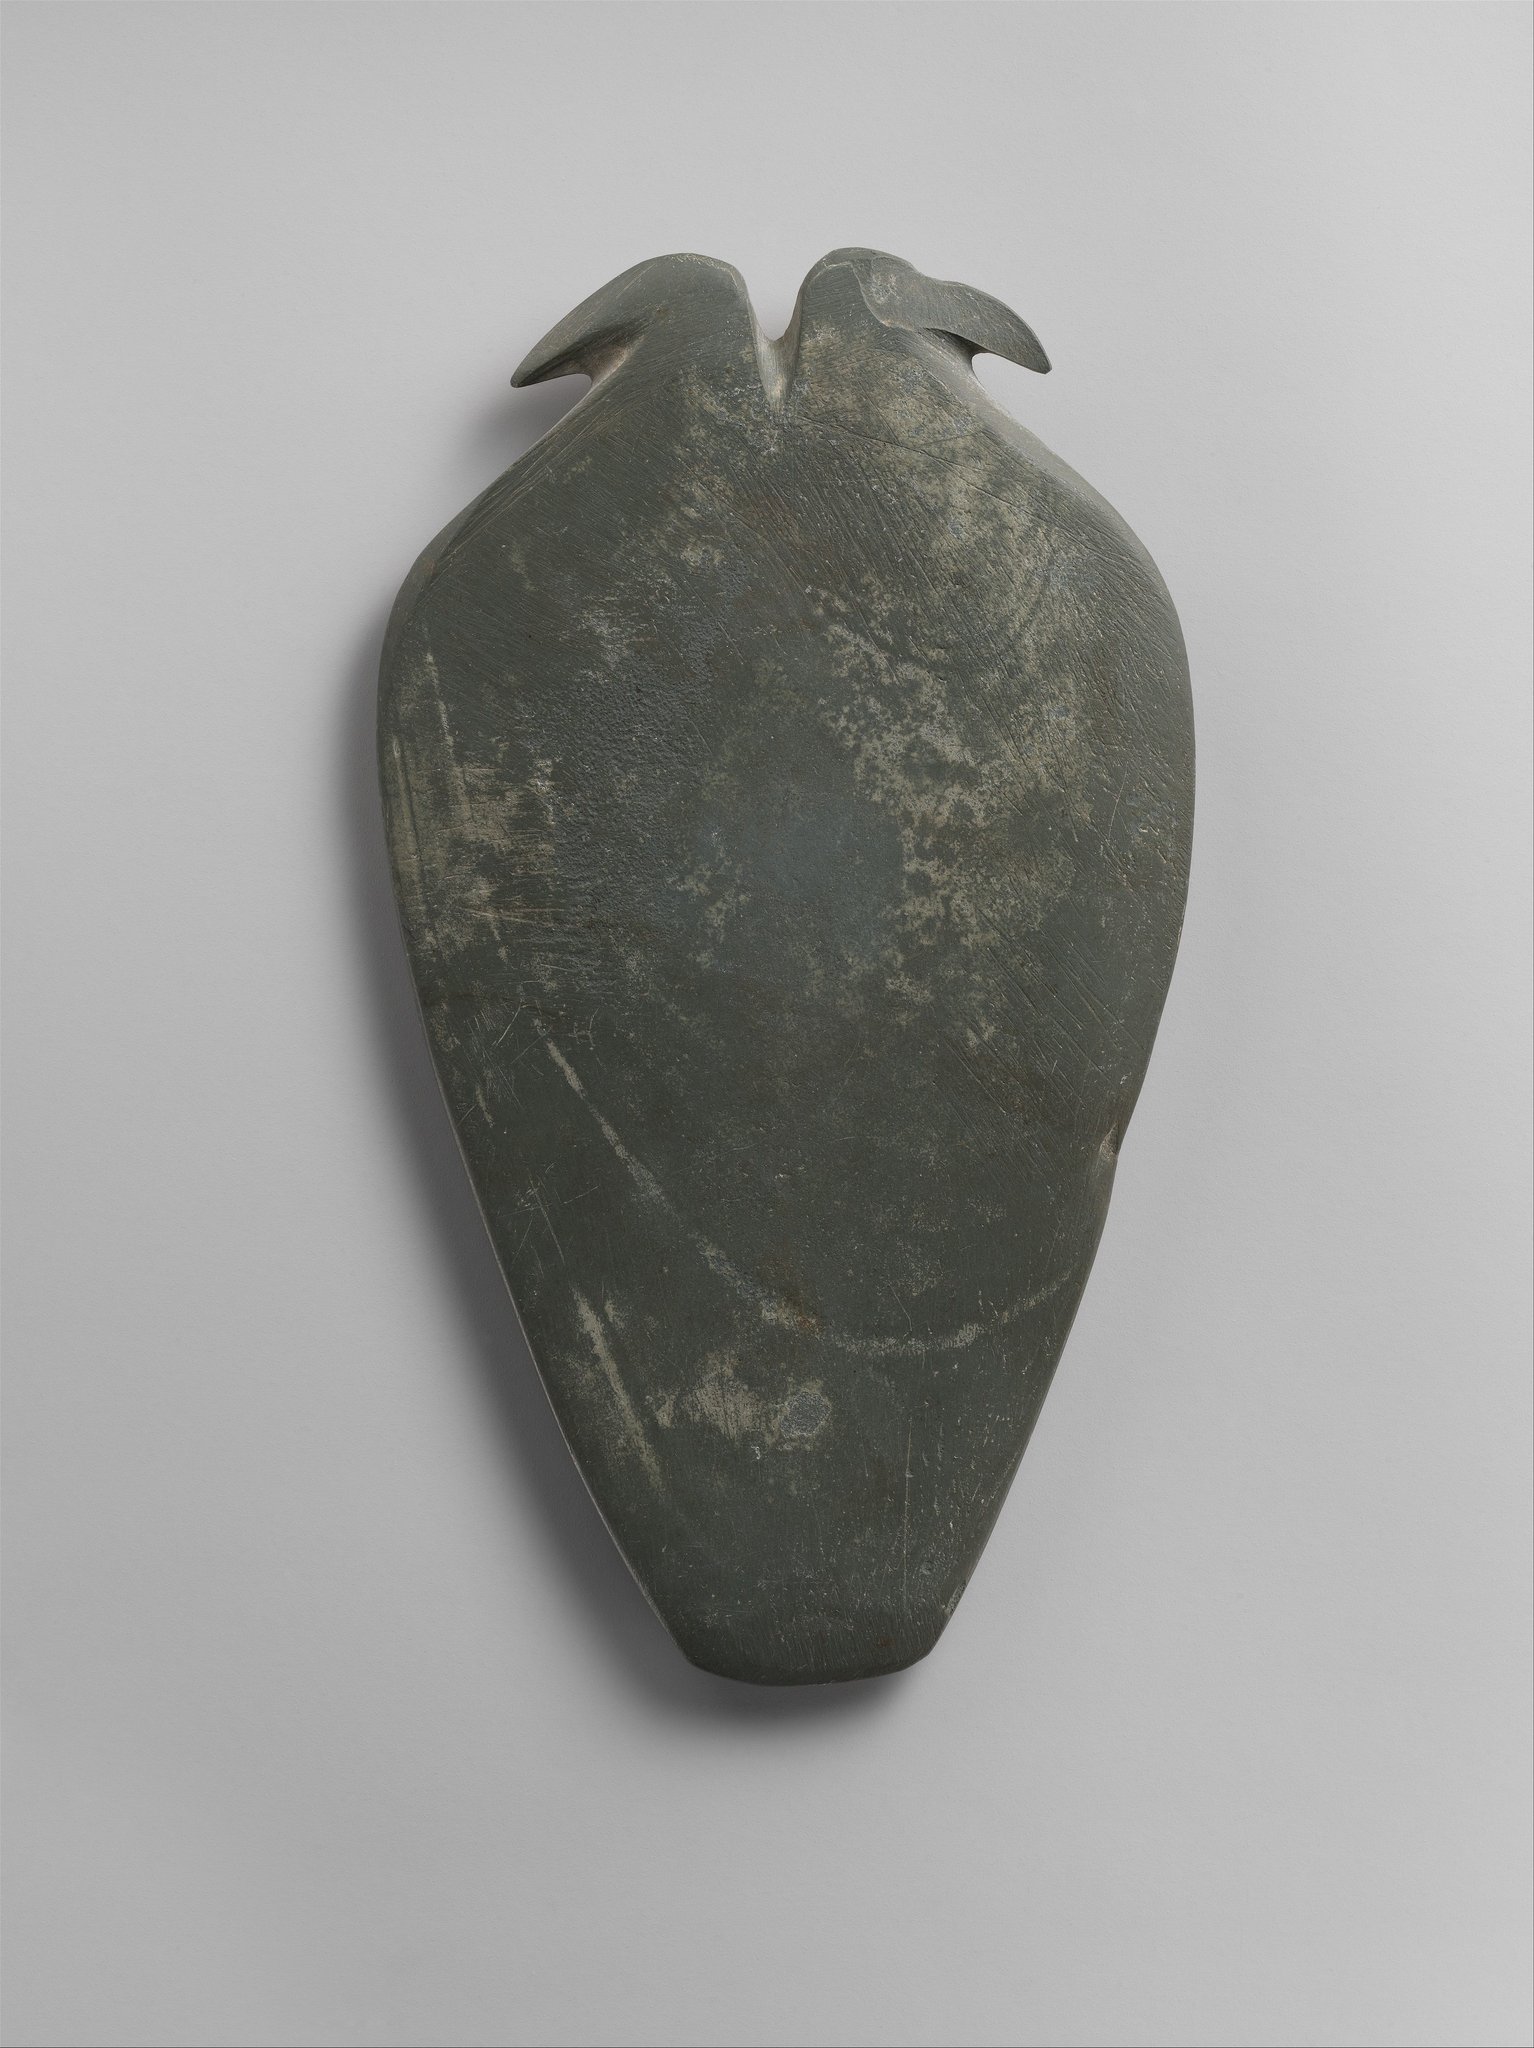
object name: palette, double bird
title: Double bird palette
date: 3500-3300 BCE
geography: egypt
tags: birds